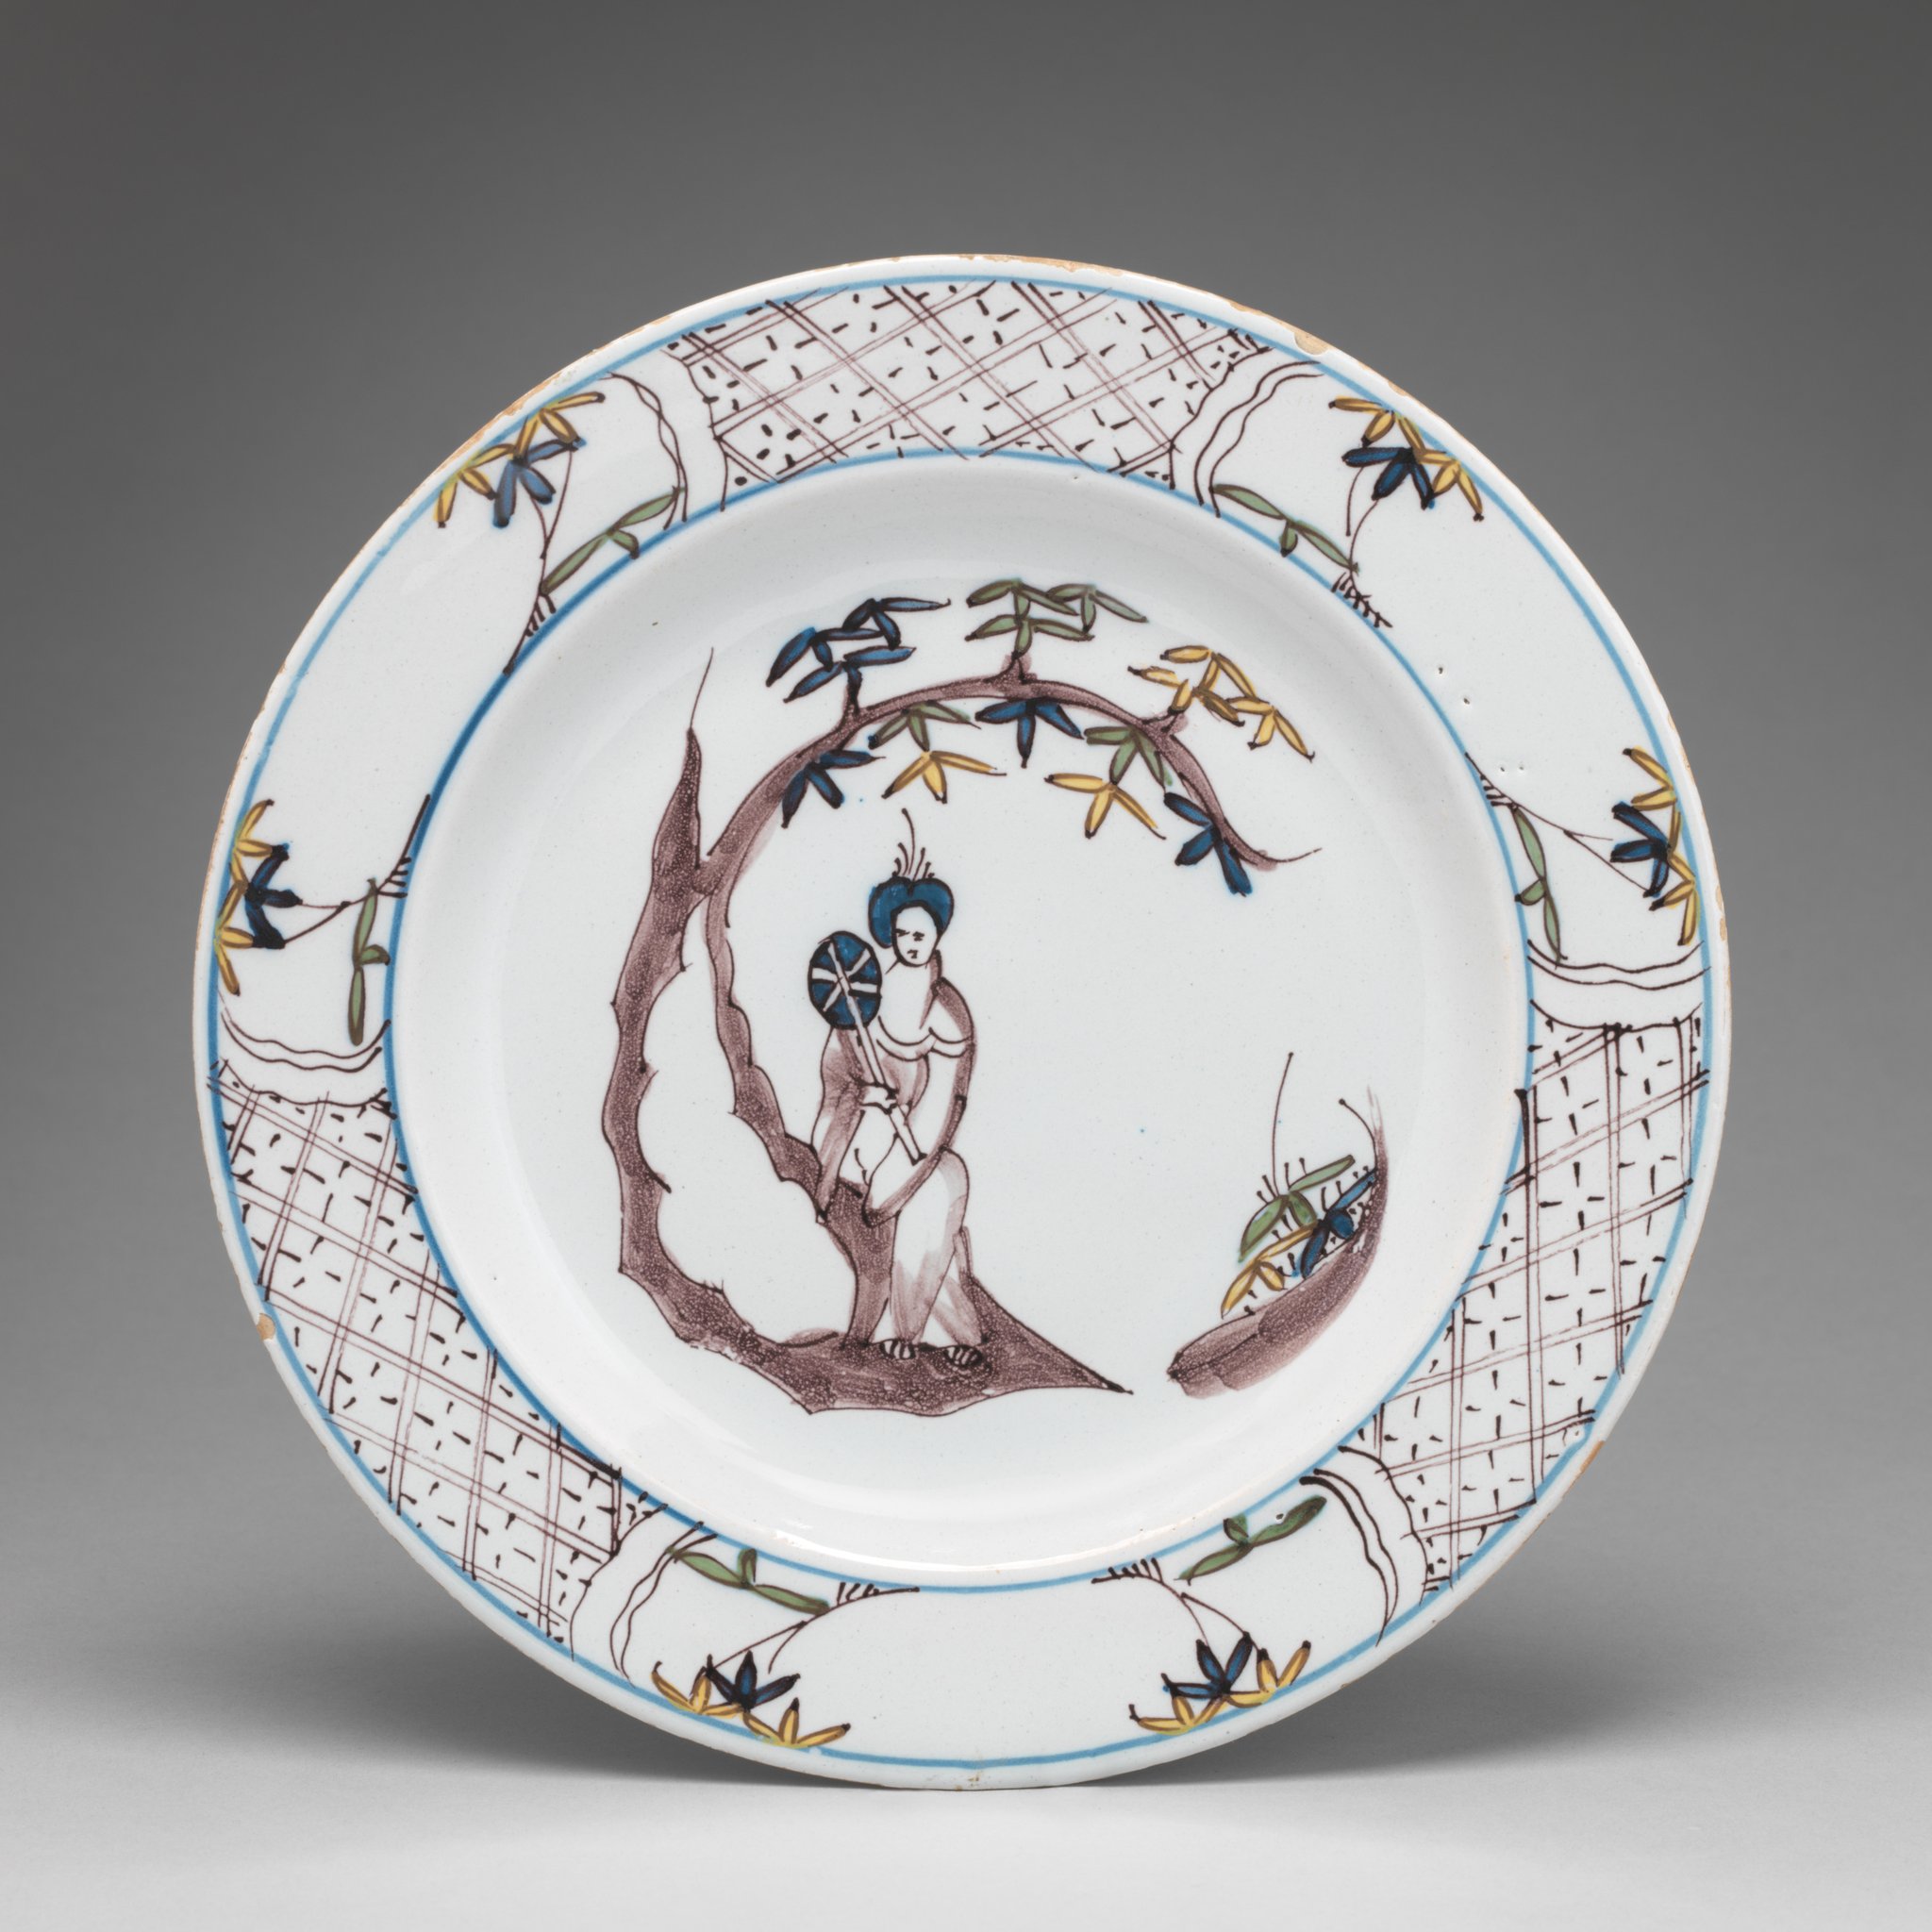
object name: plate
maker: thomas cantle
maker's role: maker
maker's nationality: british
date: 1750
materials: earthenware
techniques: glazing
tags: women